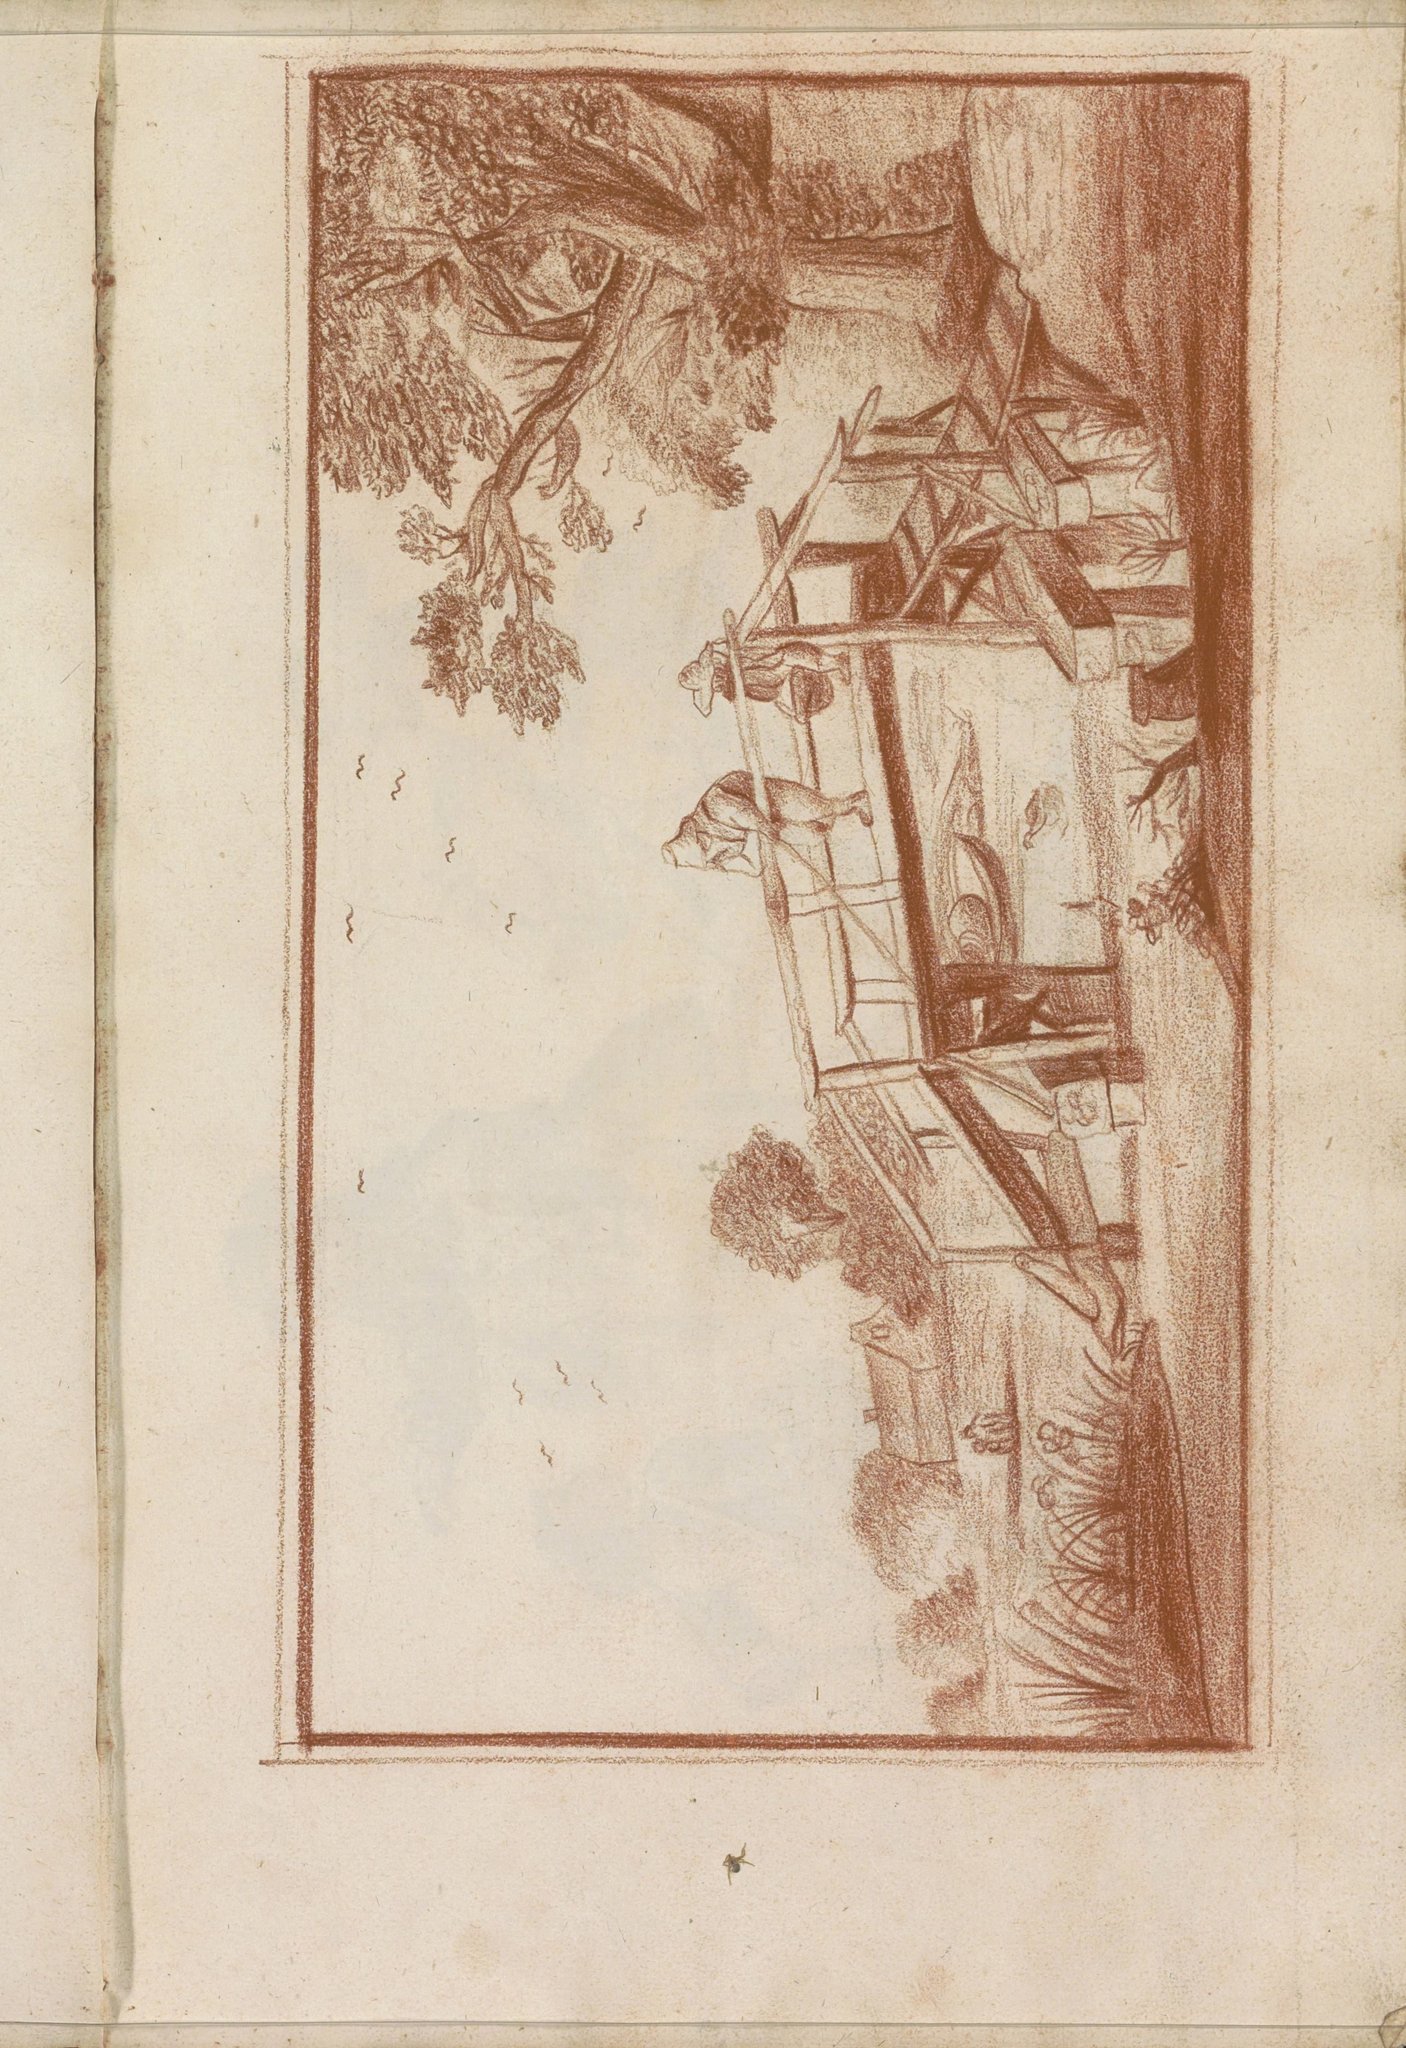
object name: sketchbook leaf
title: Twee vissers op een brug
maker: hendrick van beaumont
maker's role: draughtsman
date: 1696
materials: chalk, paper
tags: bridge, landscapes with waters, waterscapes, seascapes (in the temperate zone) (+ landscape with figures, staffage)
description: Blad 51 recto uit een schetsboek met 91 bladen.